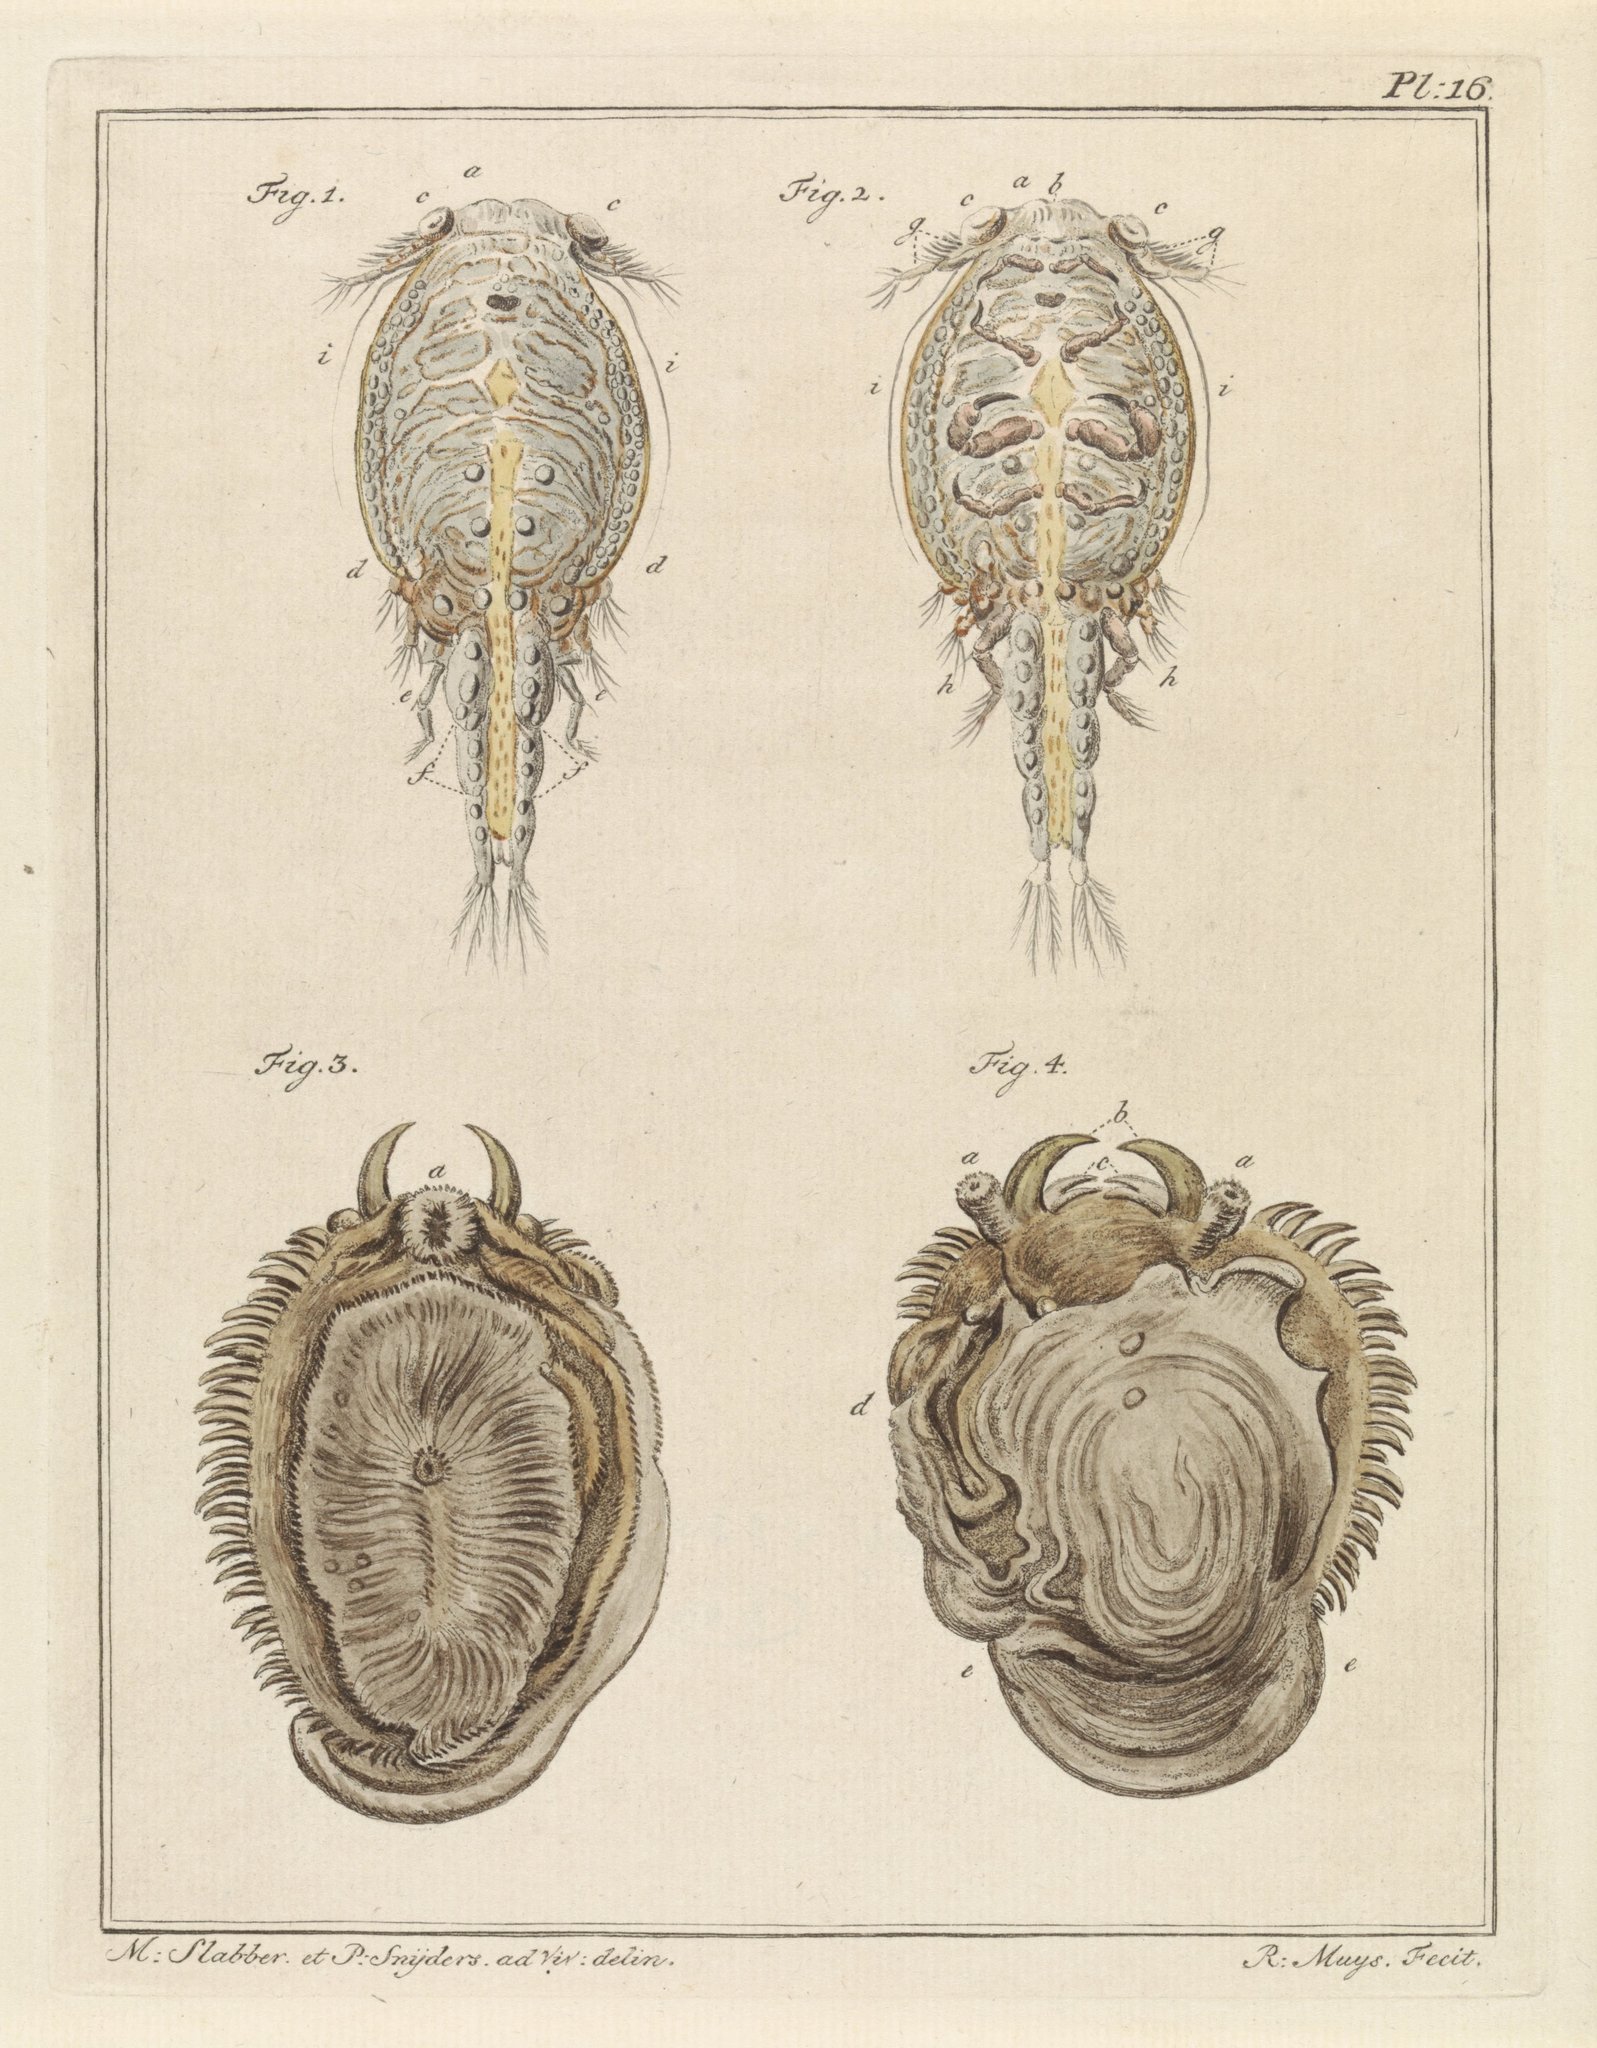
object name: print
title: Schaaldier en weekdier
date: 1778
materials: paper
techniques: etching, hand coloring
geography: rotterdam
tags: crustaceans, lower animals (+ animals ~ biological investigation), molluscs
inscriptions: collector's mark: Lugt 2228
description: Figuur 1 en 2 tonen het jeugdstadium van een parasitaire copepode bij vissen. Figuur 3 en 4 tonen zeeoor, zonder schelp. Rechtsboven: Pl. 16. Prent uit een boek over binnen- en buitenlandse land- en waterdieren.